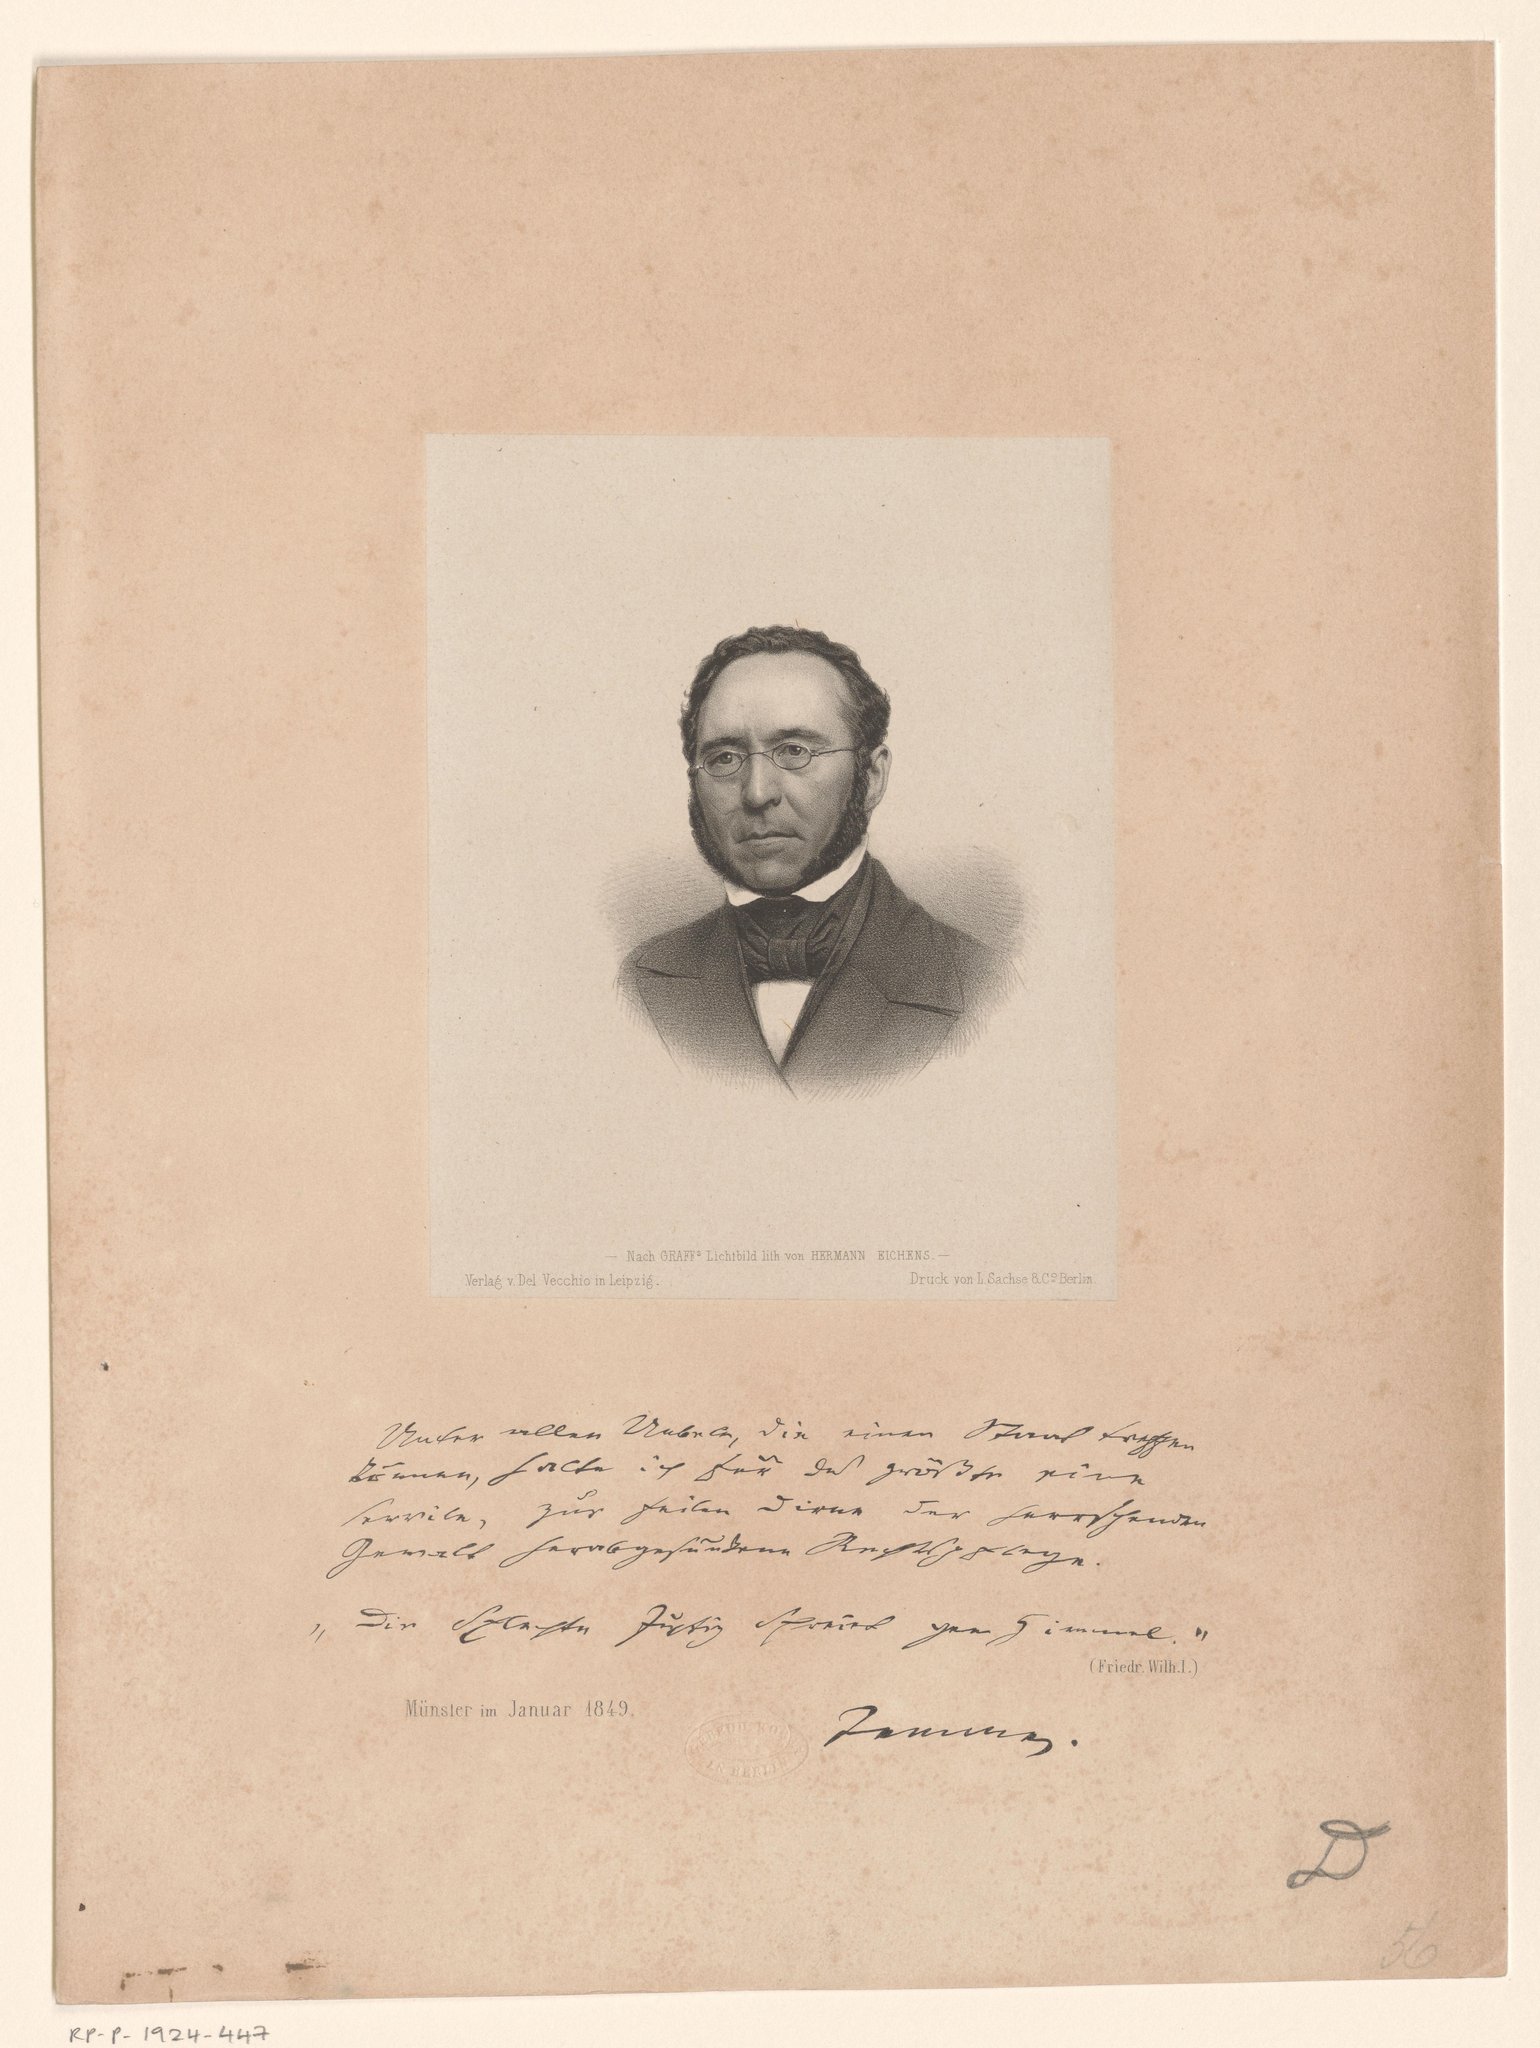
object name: print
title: Portret van Jodocus Temme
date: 1849-1854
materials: paper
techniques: lithograph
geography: leipzig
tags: westphalia, politician, historical persons, politician, e.g. party leader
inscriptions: collector's mark: Lugt 2228, workshop stamp: Lugt 2141c